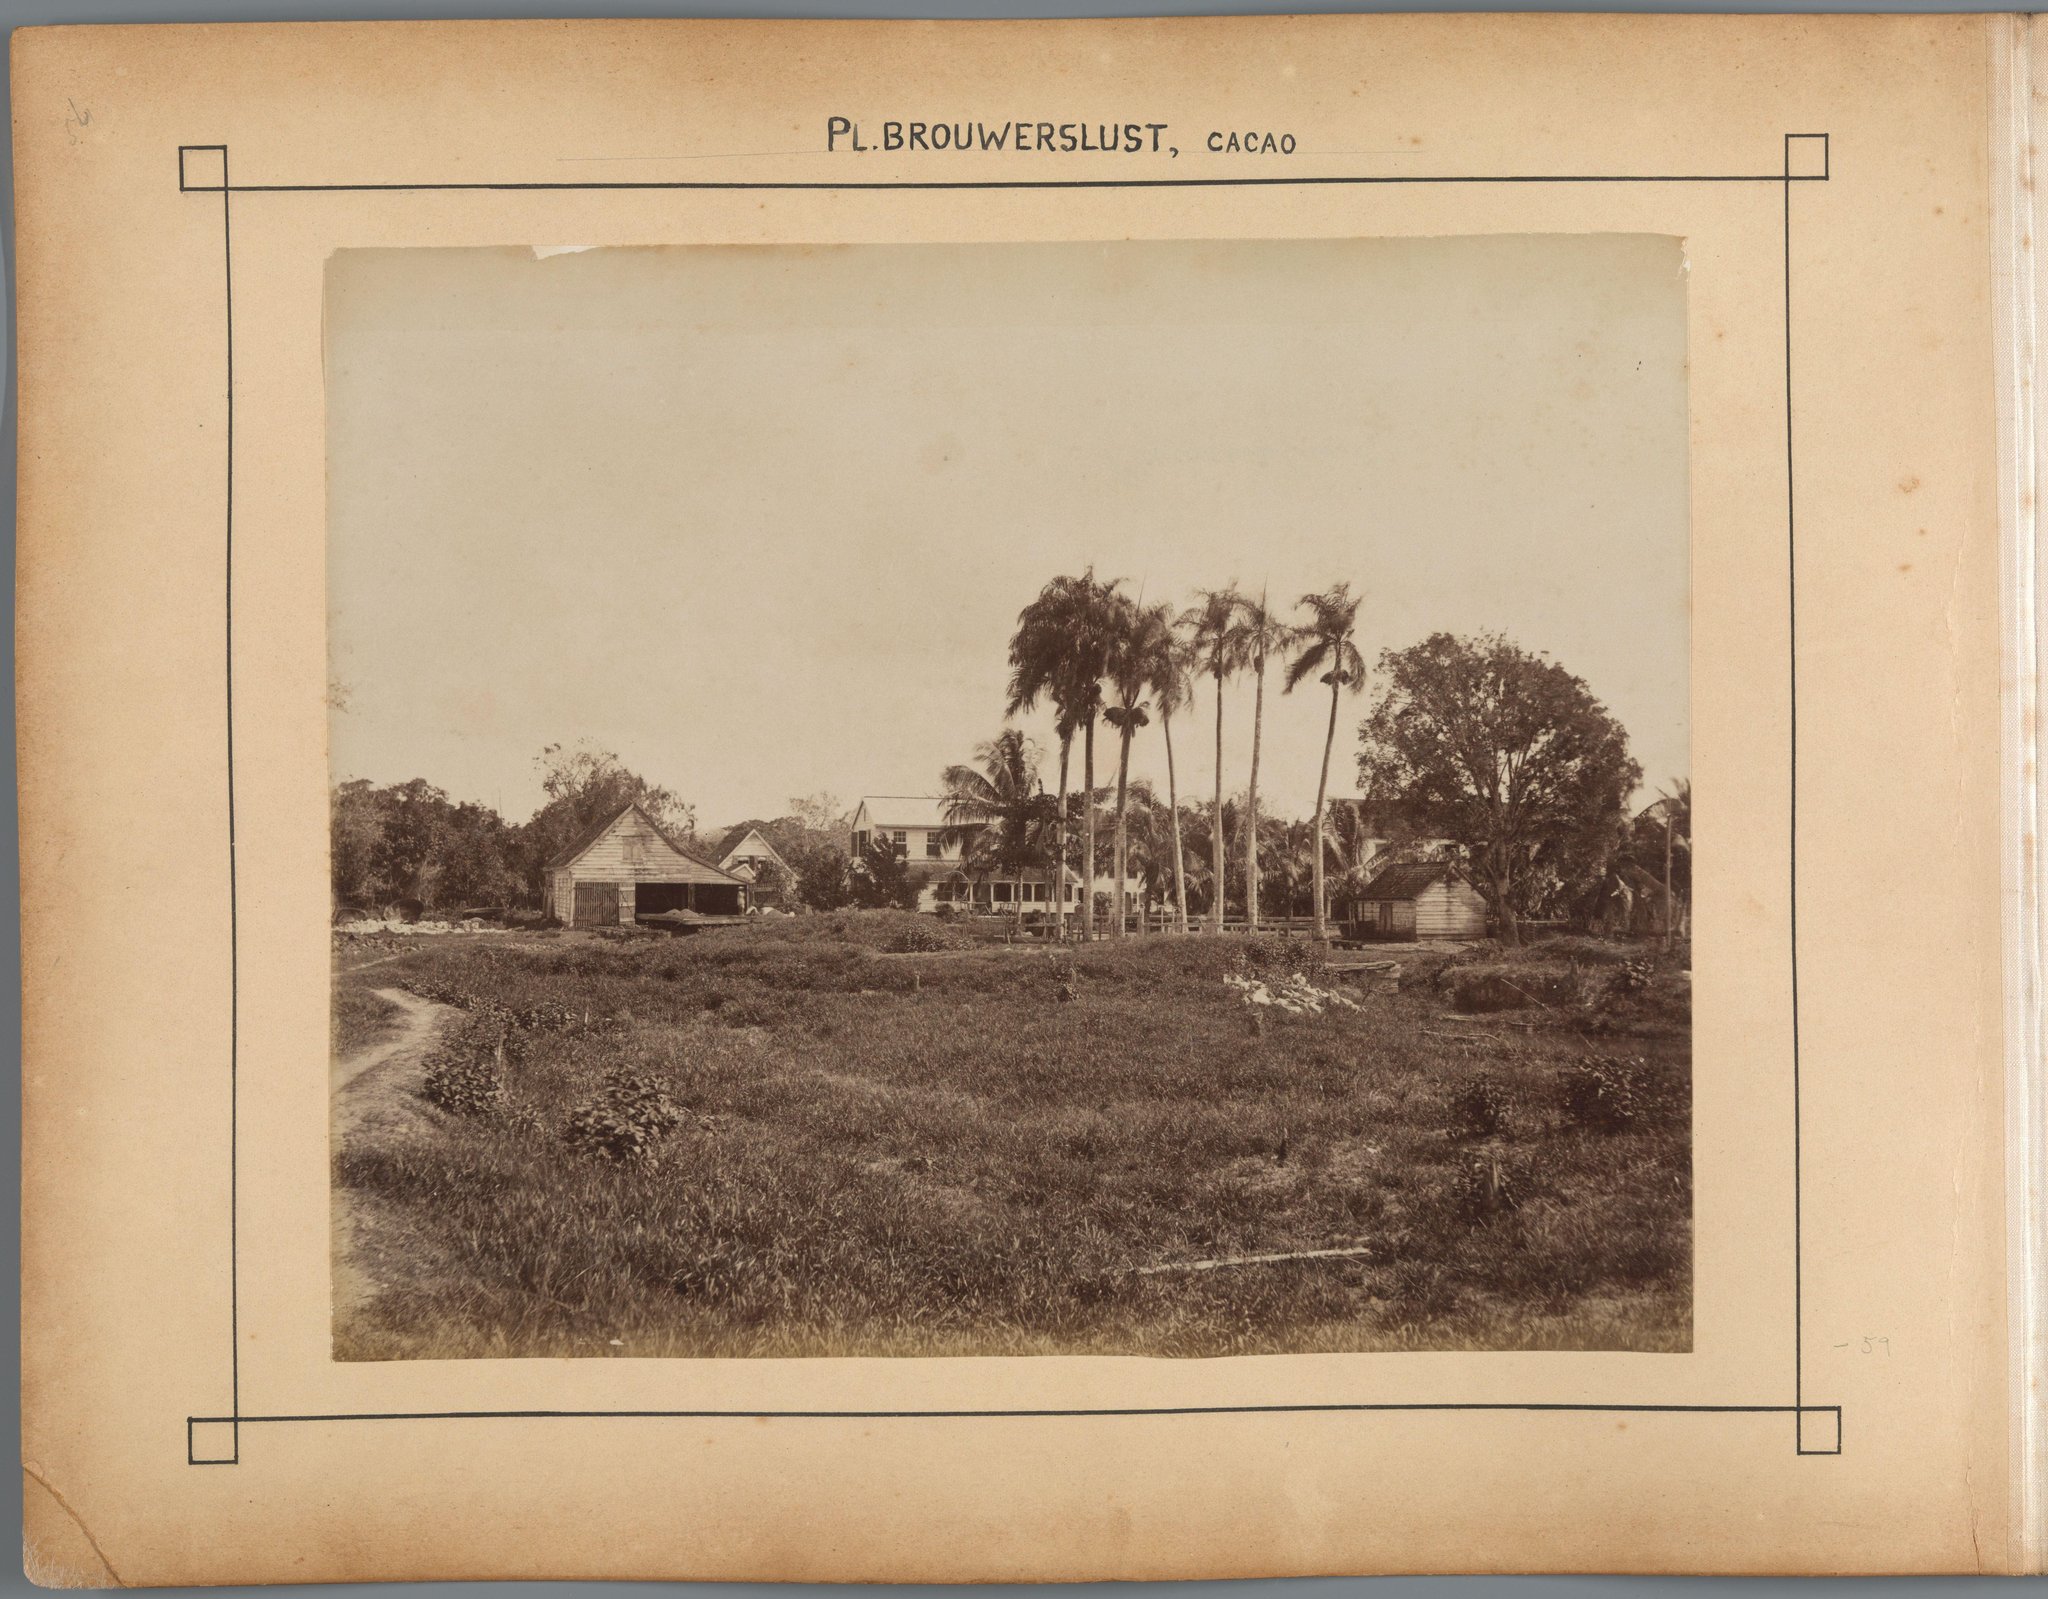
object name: photograph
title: Pl. Brouwerslust, cacao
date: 1898-1902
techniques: albumen print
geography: suriname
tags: plantation, chocolate, cocoa, suriname